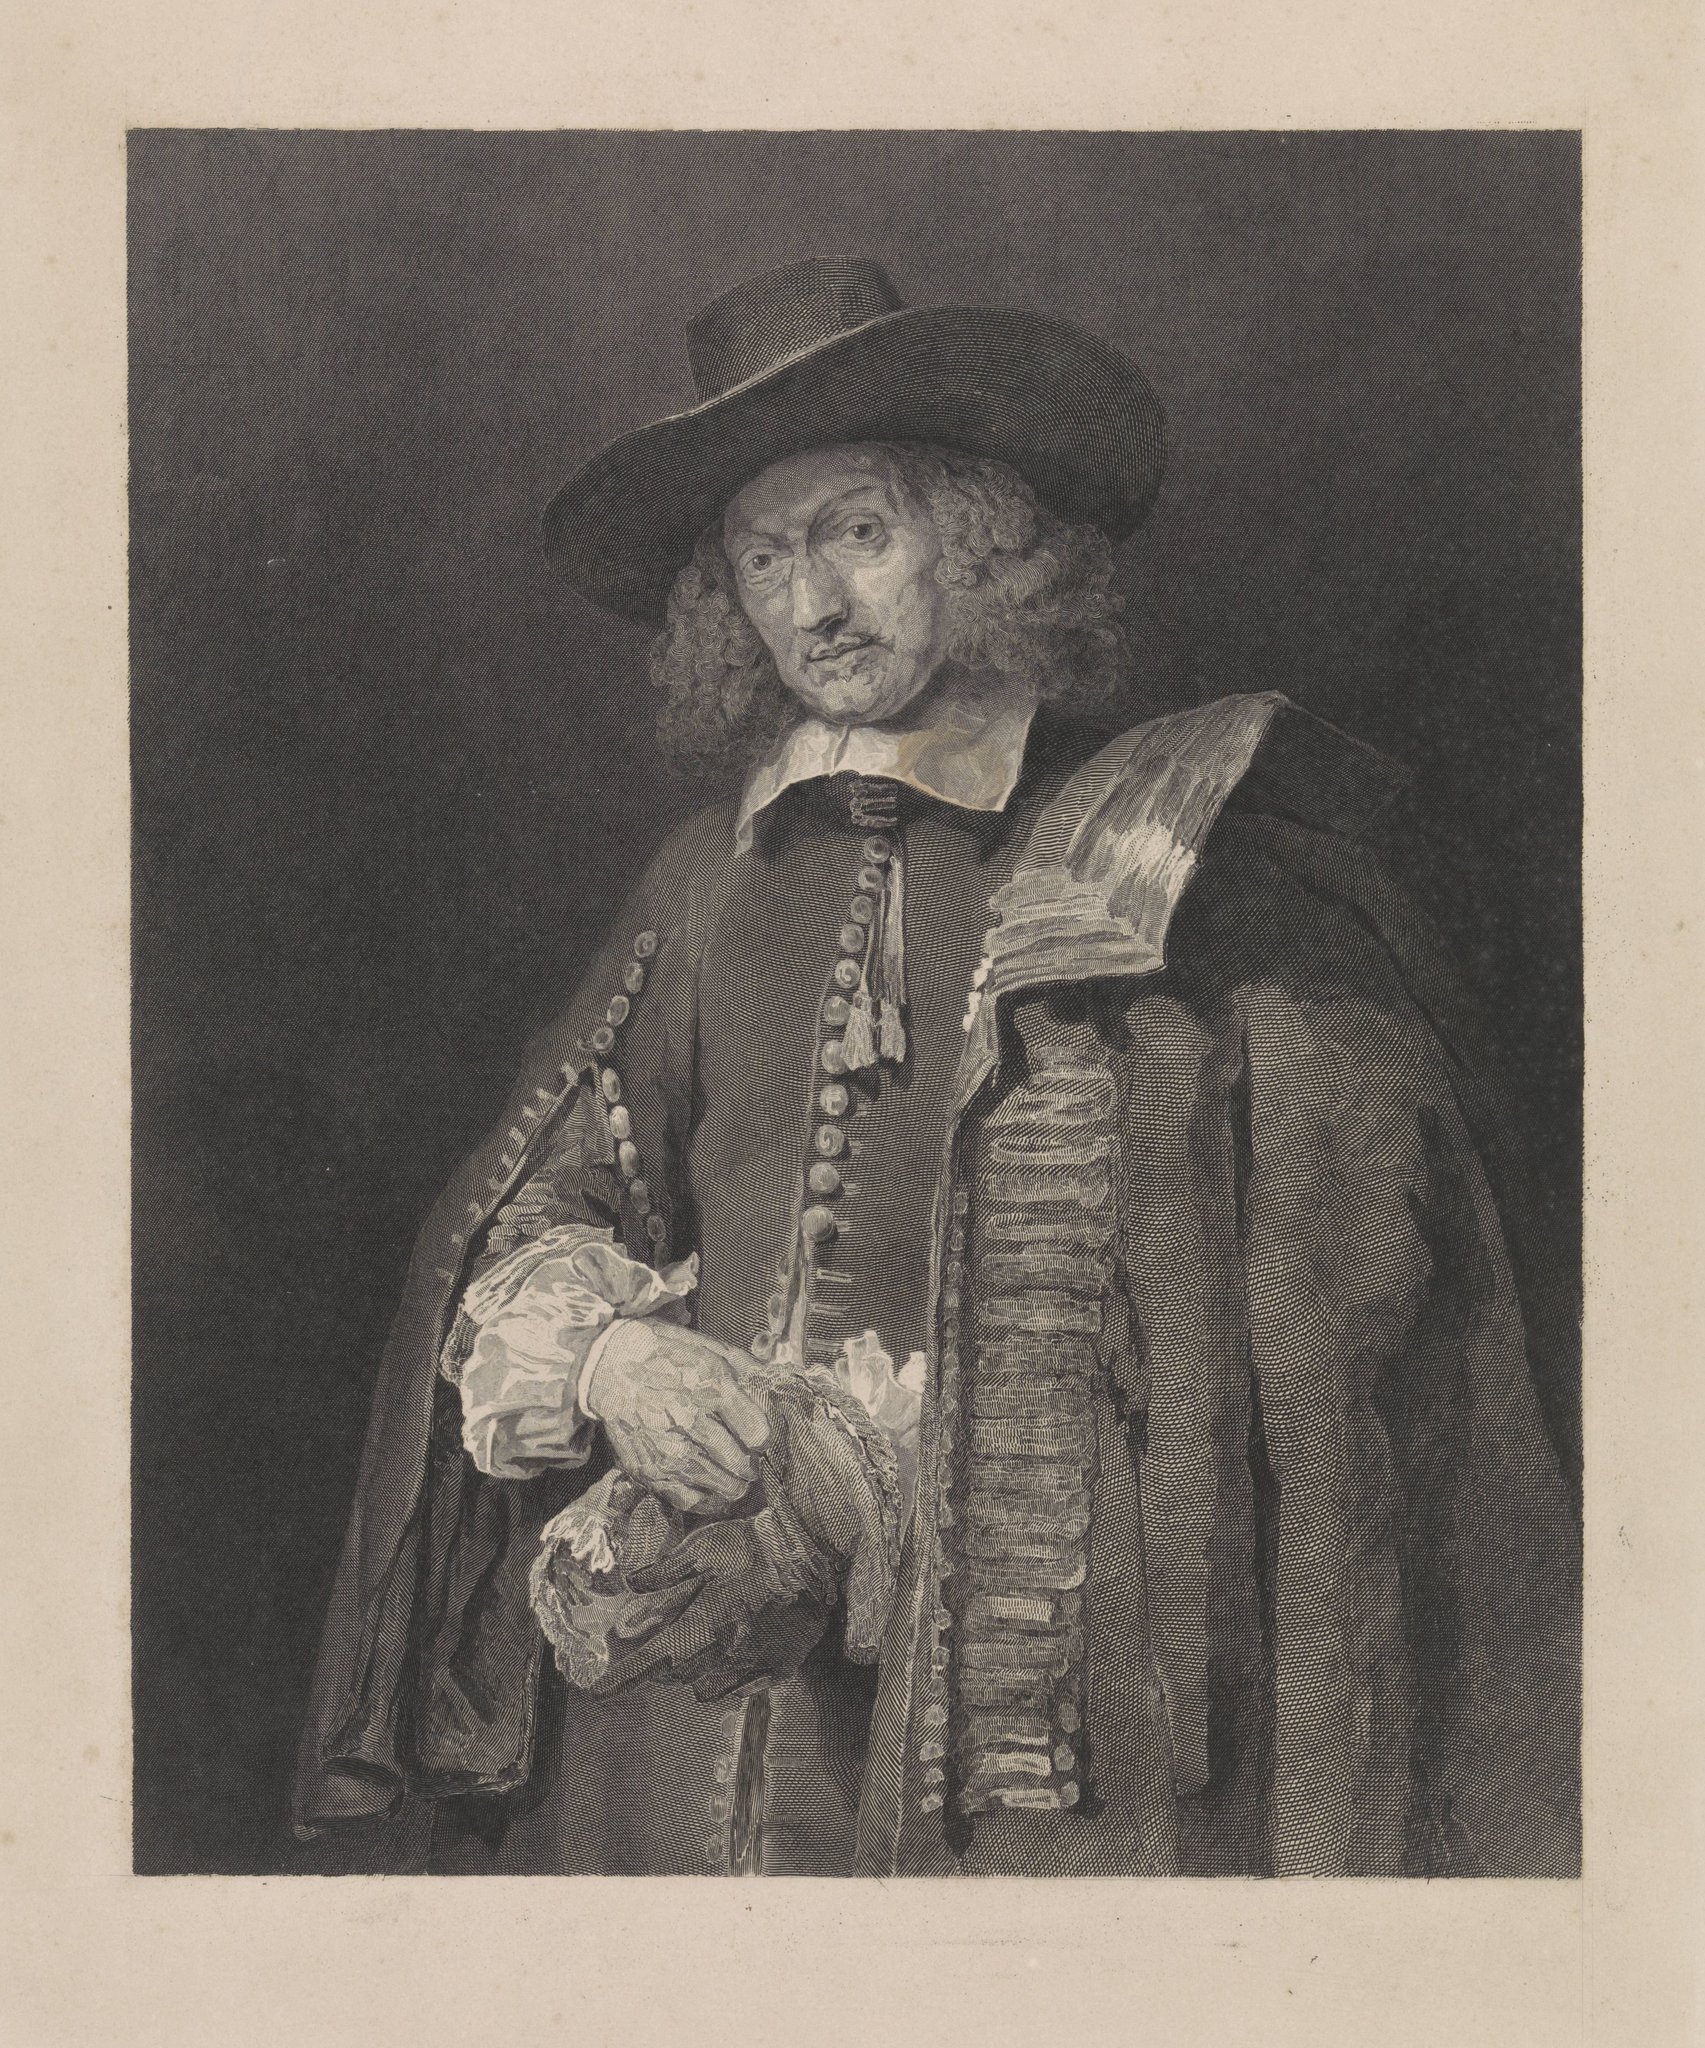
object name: print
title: Portret van Jan Six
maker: johann wilhelm kaiser (i)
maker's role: draughtsman, print maker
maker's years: 1813-1900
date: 1823-1853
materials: paper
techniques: engraving, etching, roulette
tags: amsterdam, mayor, jan six (1618-1700)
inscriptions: collector's mark: Lugt 2228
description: Portret ten halven lijve van Jan Six, burgemeester van Amsterdam.